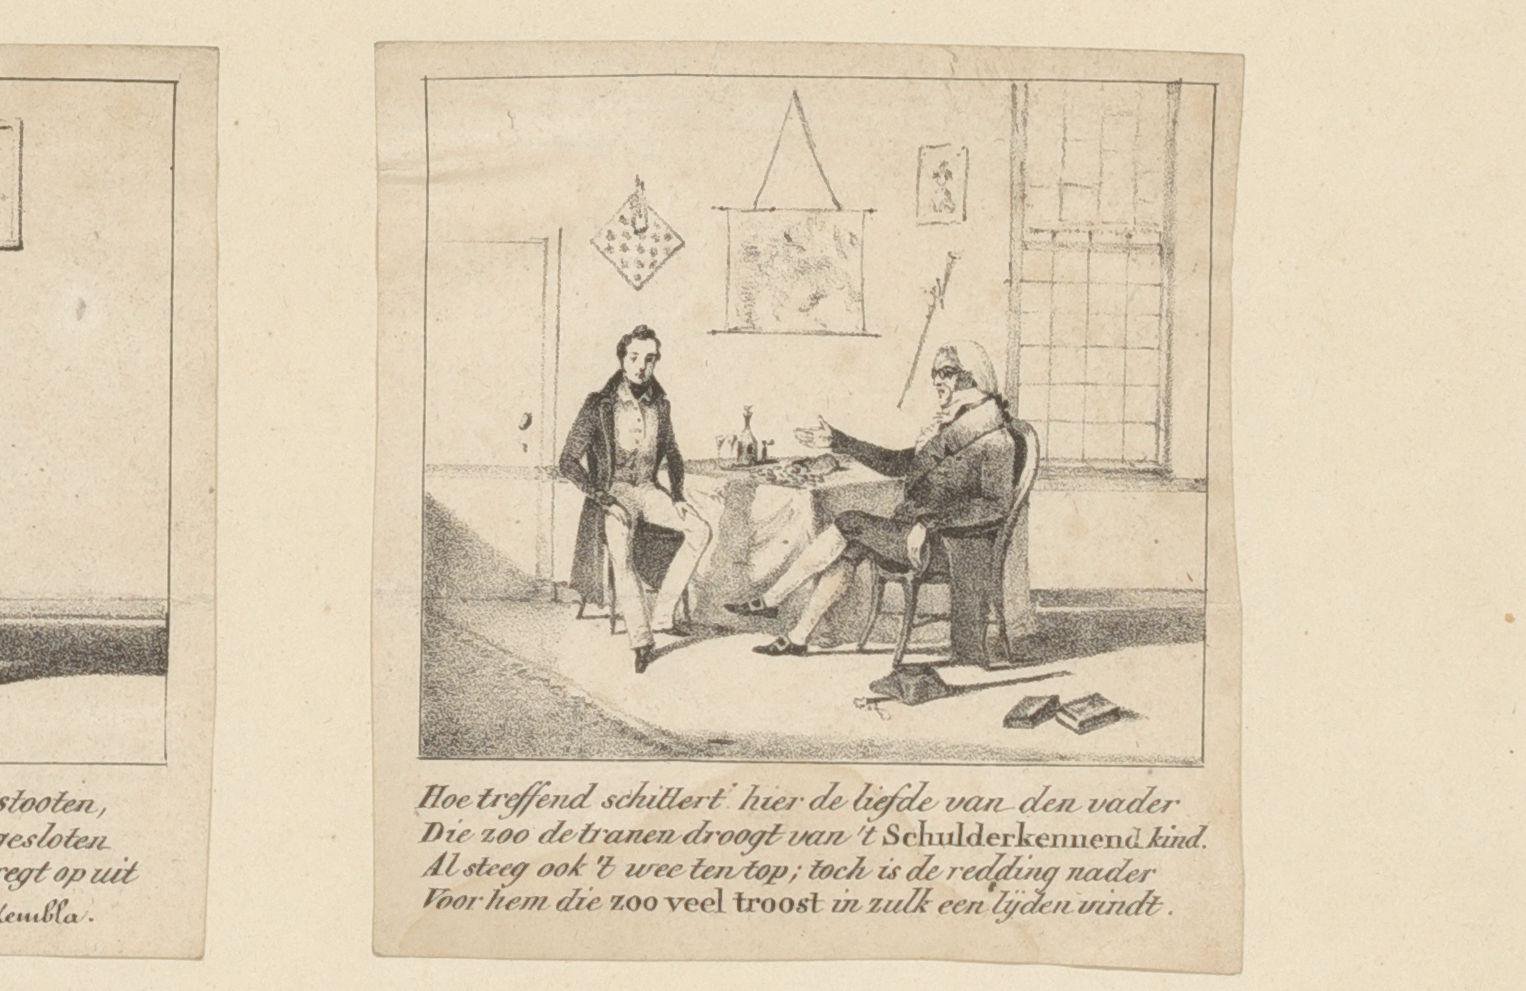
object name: print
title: Oude en een jonge man aan tafel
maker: Anonymous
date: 1835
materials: paper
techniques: lithograph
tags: student life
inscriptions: stamp, stamp, collector's mark: Lugt 1641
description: Prent mogelijk geknipt uit een grotere prent met de titel op object: Stichtsche School-prent. Prent gepubliceerd bij: Utrechtsche Studenten almanak. Utrecht: J. van Druten, 1885.